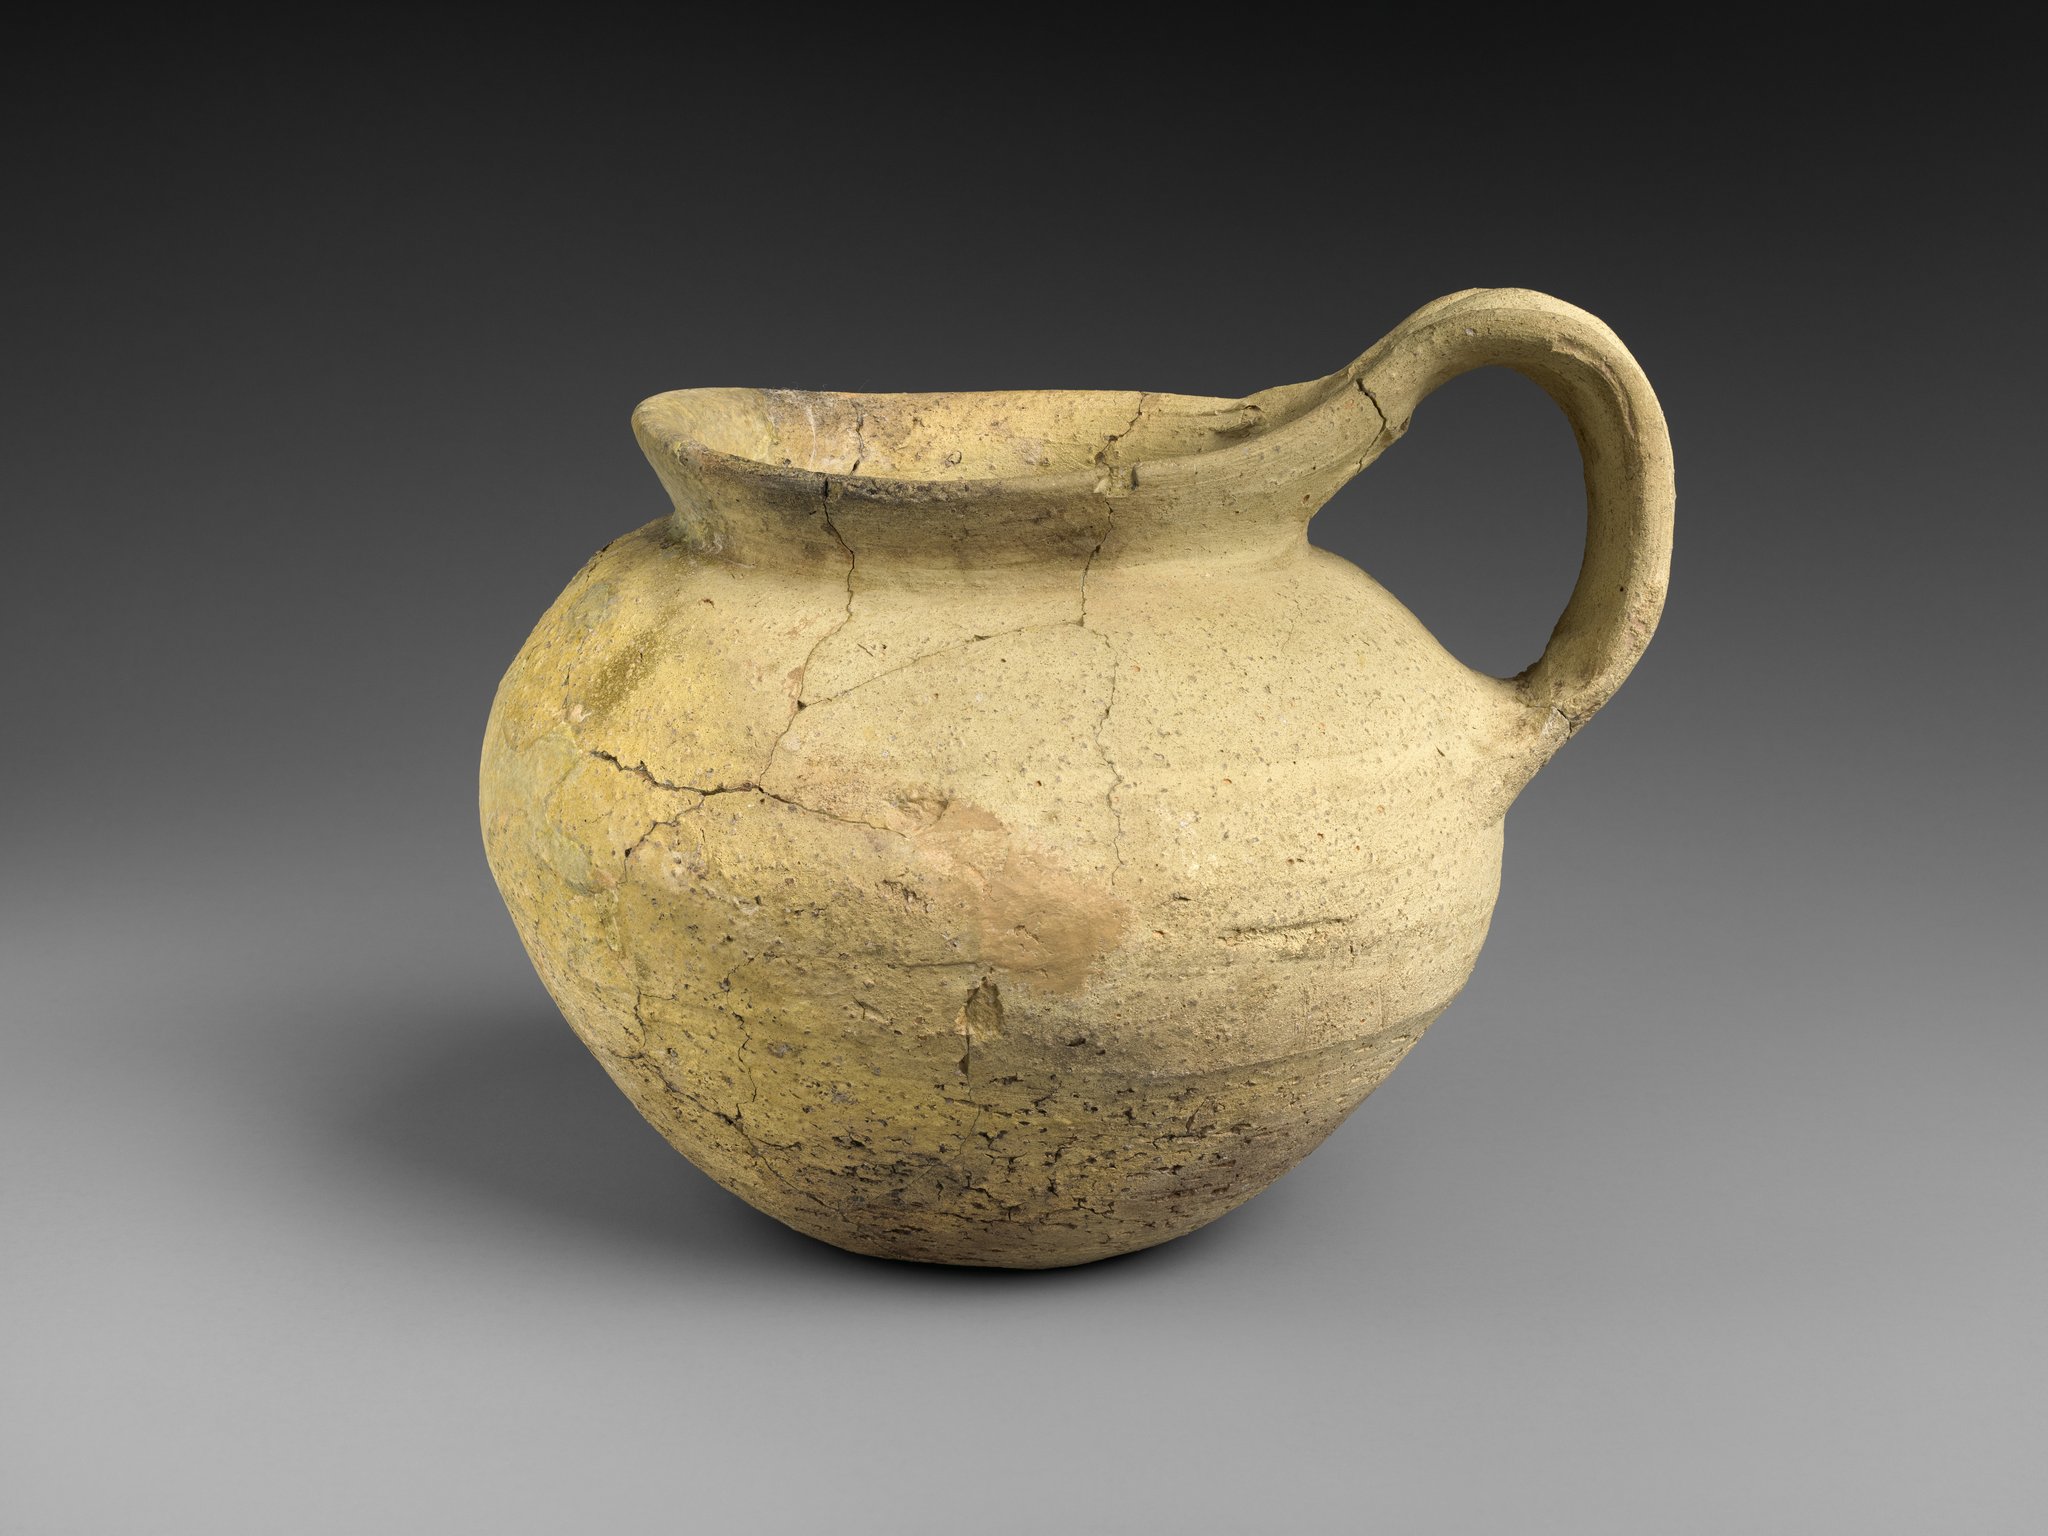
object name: pitcher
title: Pitcher with twisted strap handle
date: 3800-3600 BCE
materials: ceramic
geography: mesopotamia